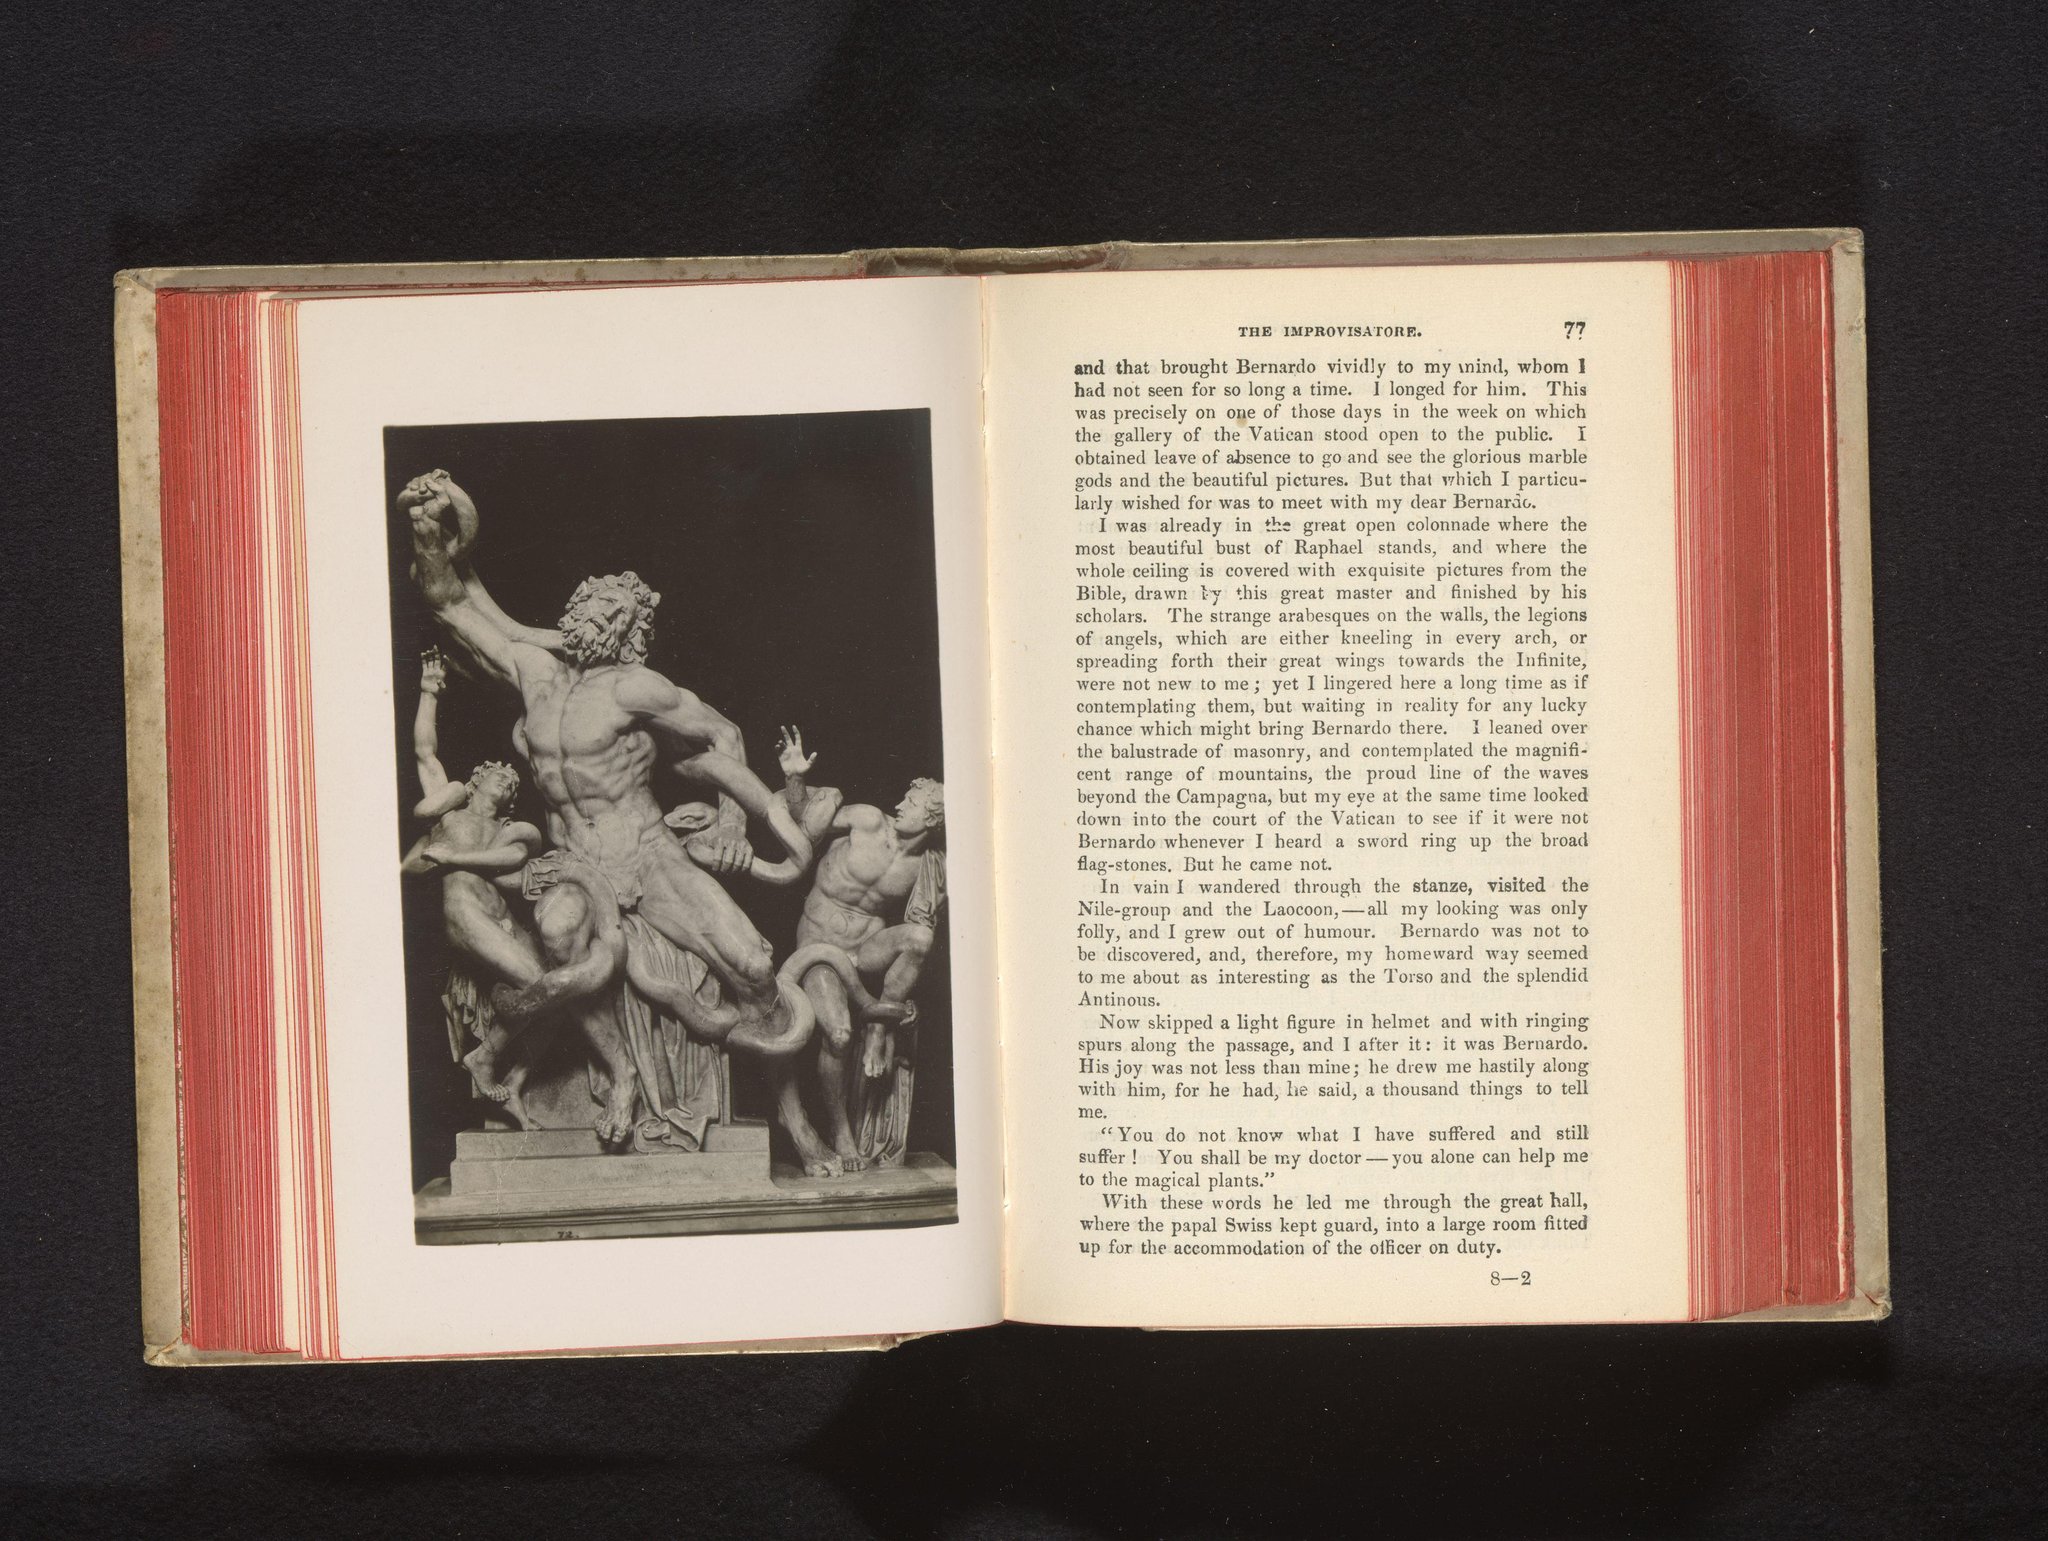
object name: photograph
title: Laocoöngroep in de Vaticaanse Musea te Vaticaanstad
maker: Anonymous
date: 1870-1880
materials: photographic support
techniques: gelatin silver print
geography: vatican museums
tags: laocoon and his twin sons are strangled by two serpents during the preparations for a sacrifice, sculpture